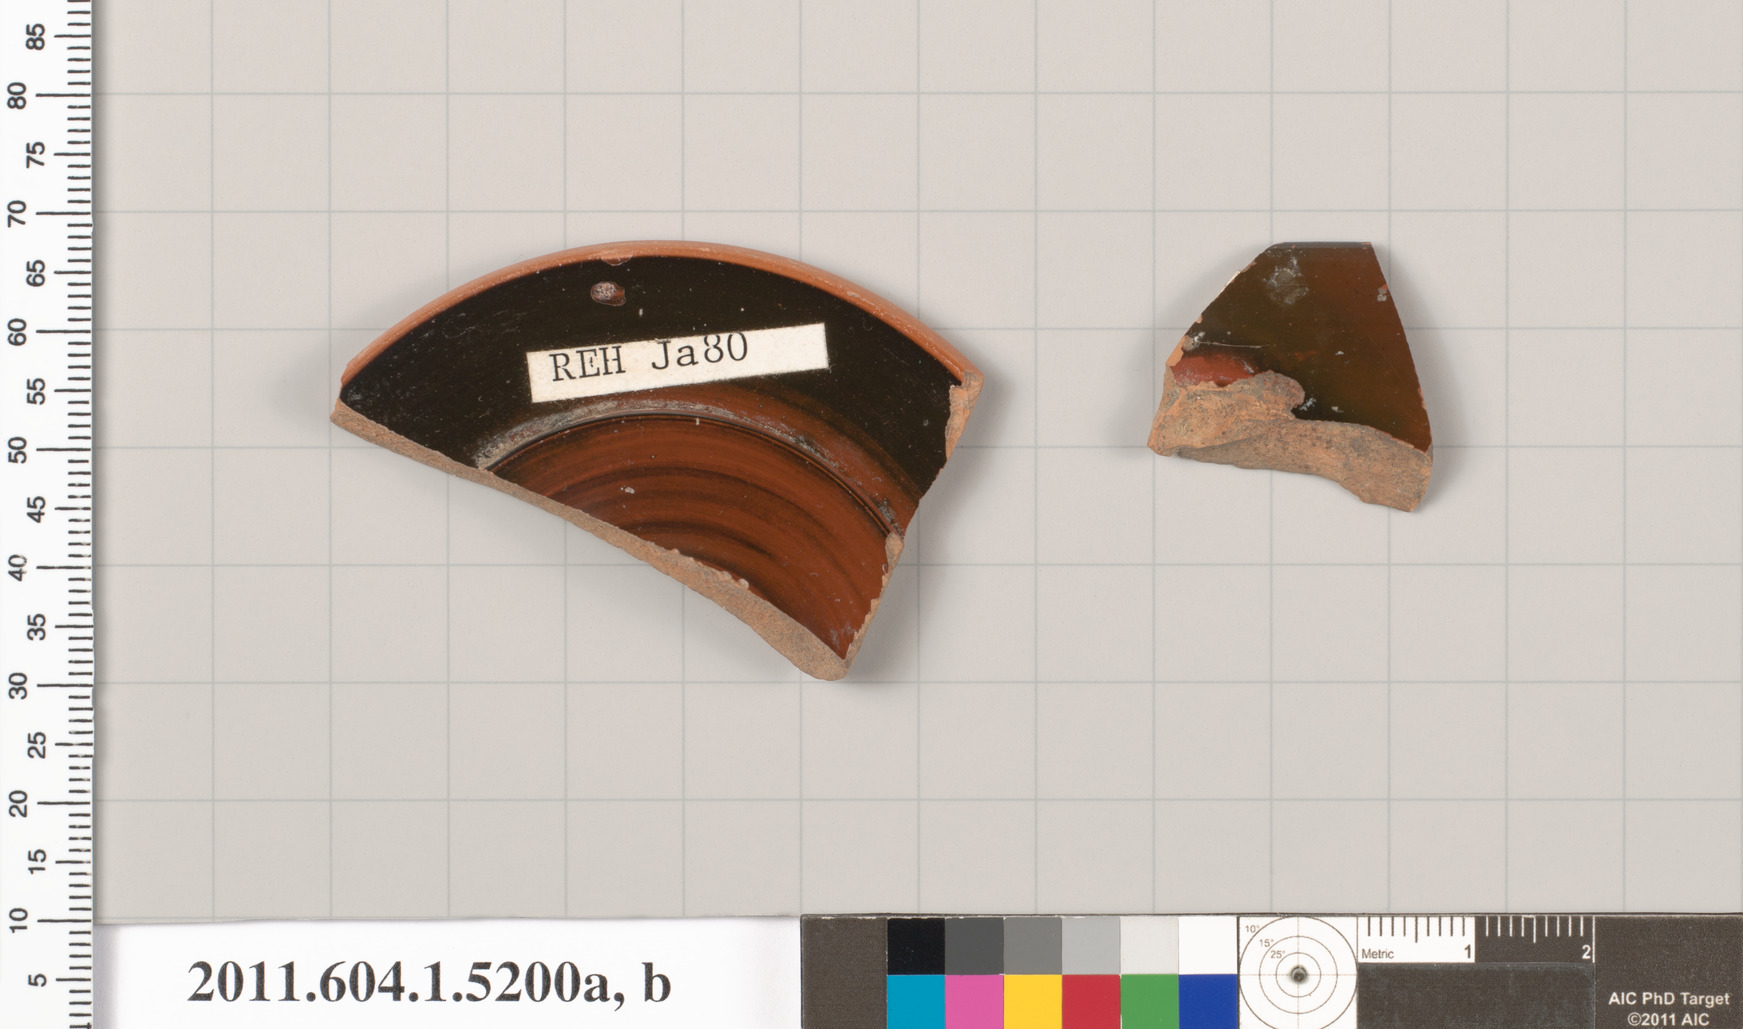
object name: kylix fragment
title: Terracotta fragments of kylikes (drinking cups)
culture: greek, attic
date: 500-451 BCE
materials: terracotta